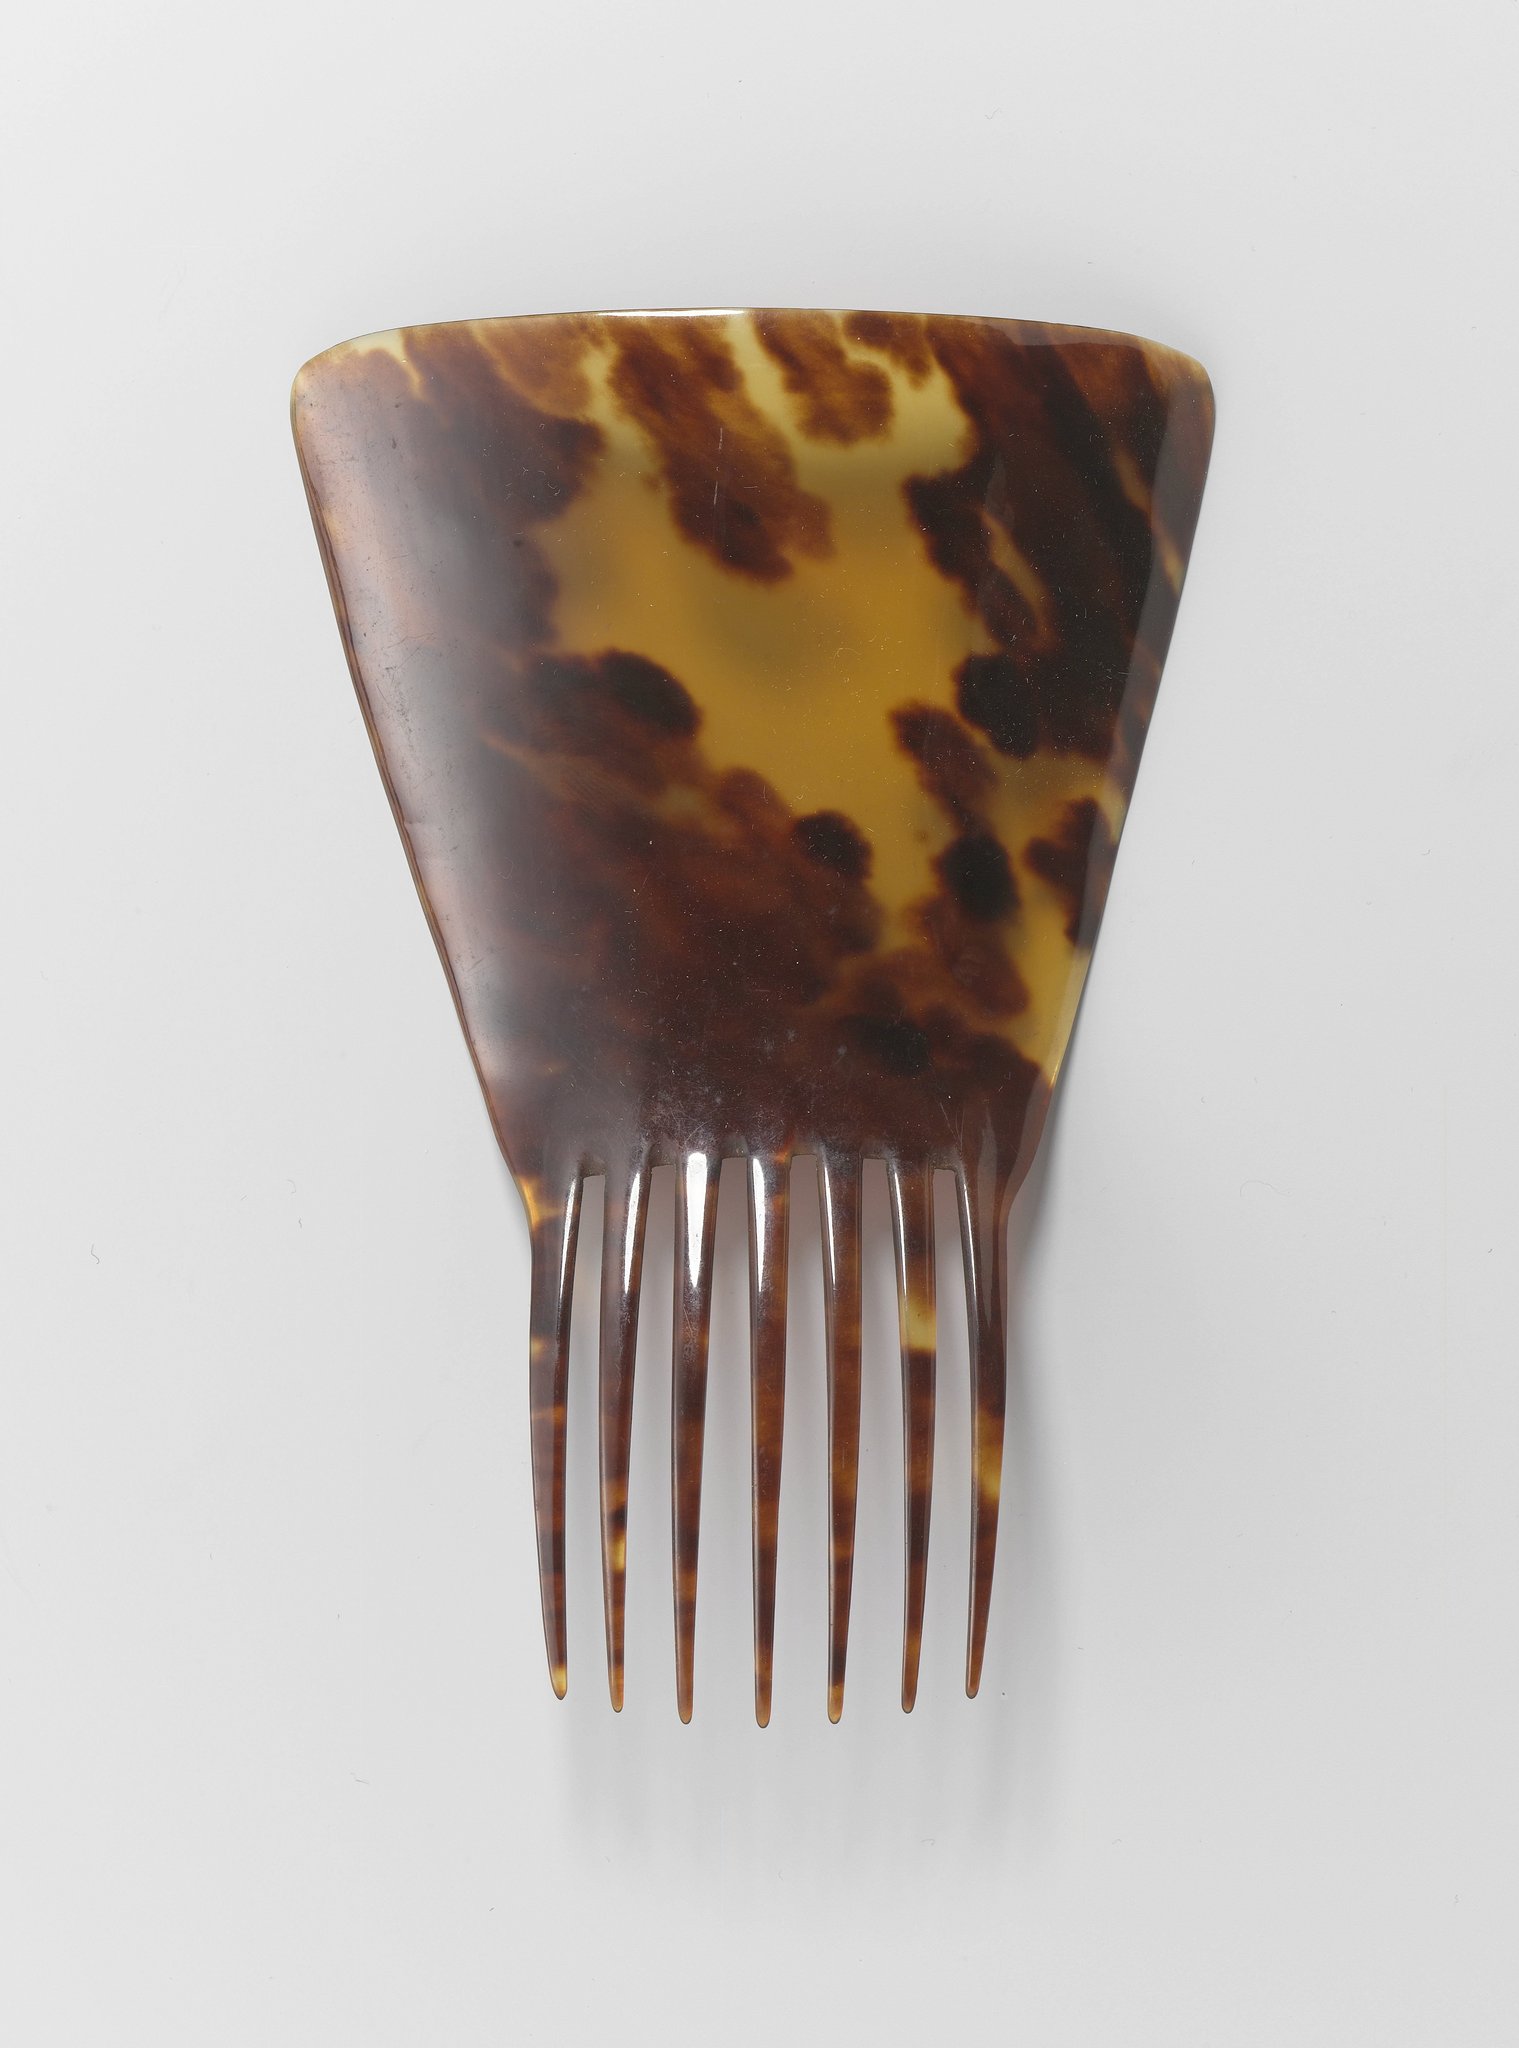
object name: comb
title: Haarkam van imitatie schildpad met gladde trapeziumvormige rug, zeven tanden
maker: Anonymous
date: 1885-1900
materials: celluloid, plastic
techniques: filing, polish, pressing, sawing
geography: netherlands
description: Een hoge trapezium-vormige mantille-kam van donker schildpad met een glad bovenstuk en zeven tanden.